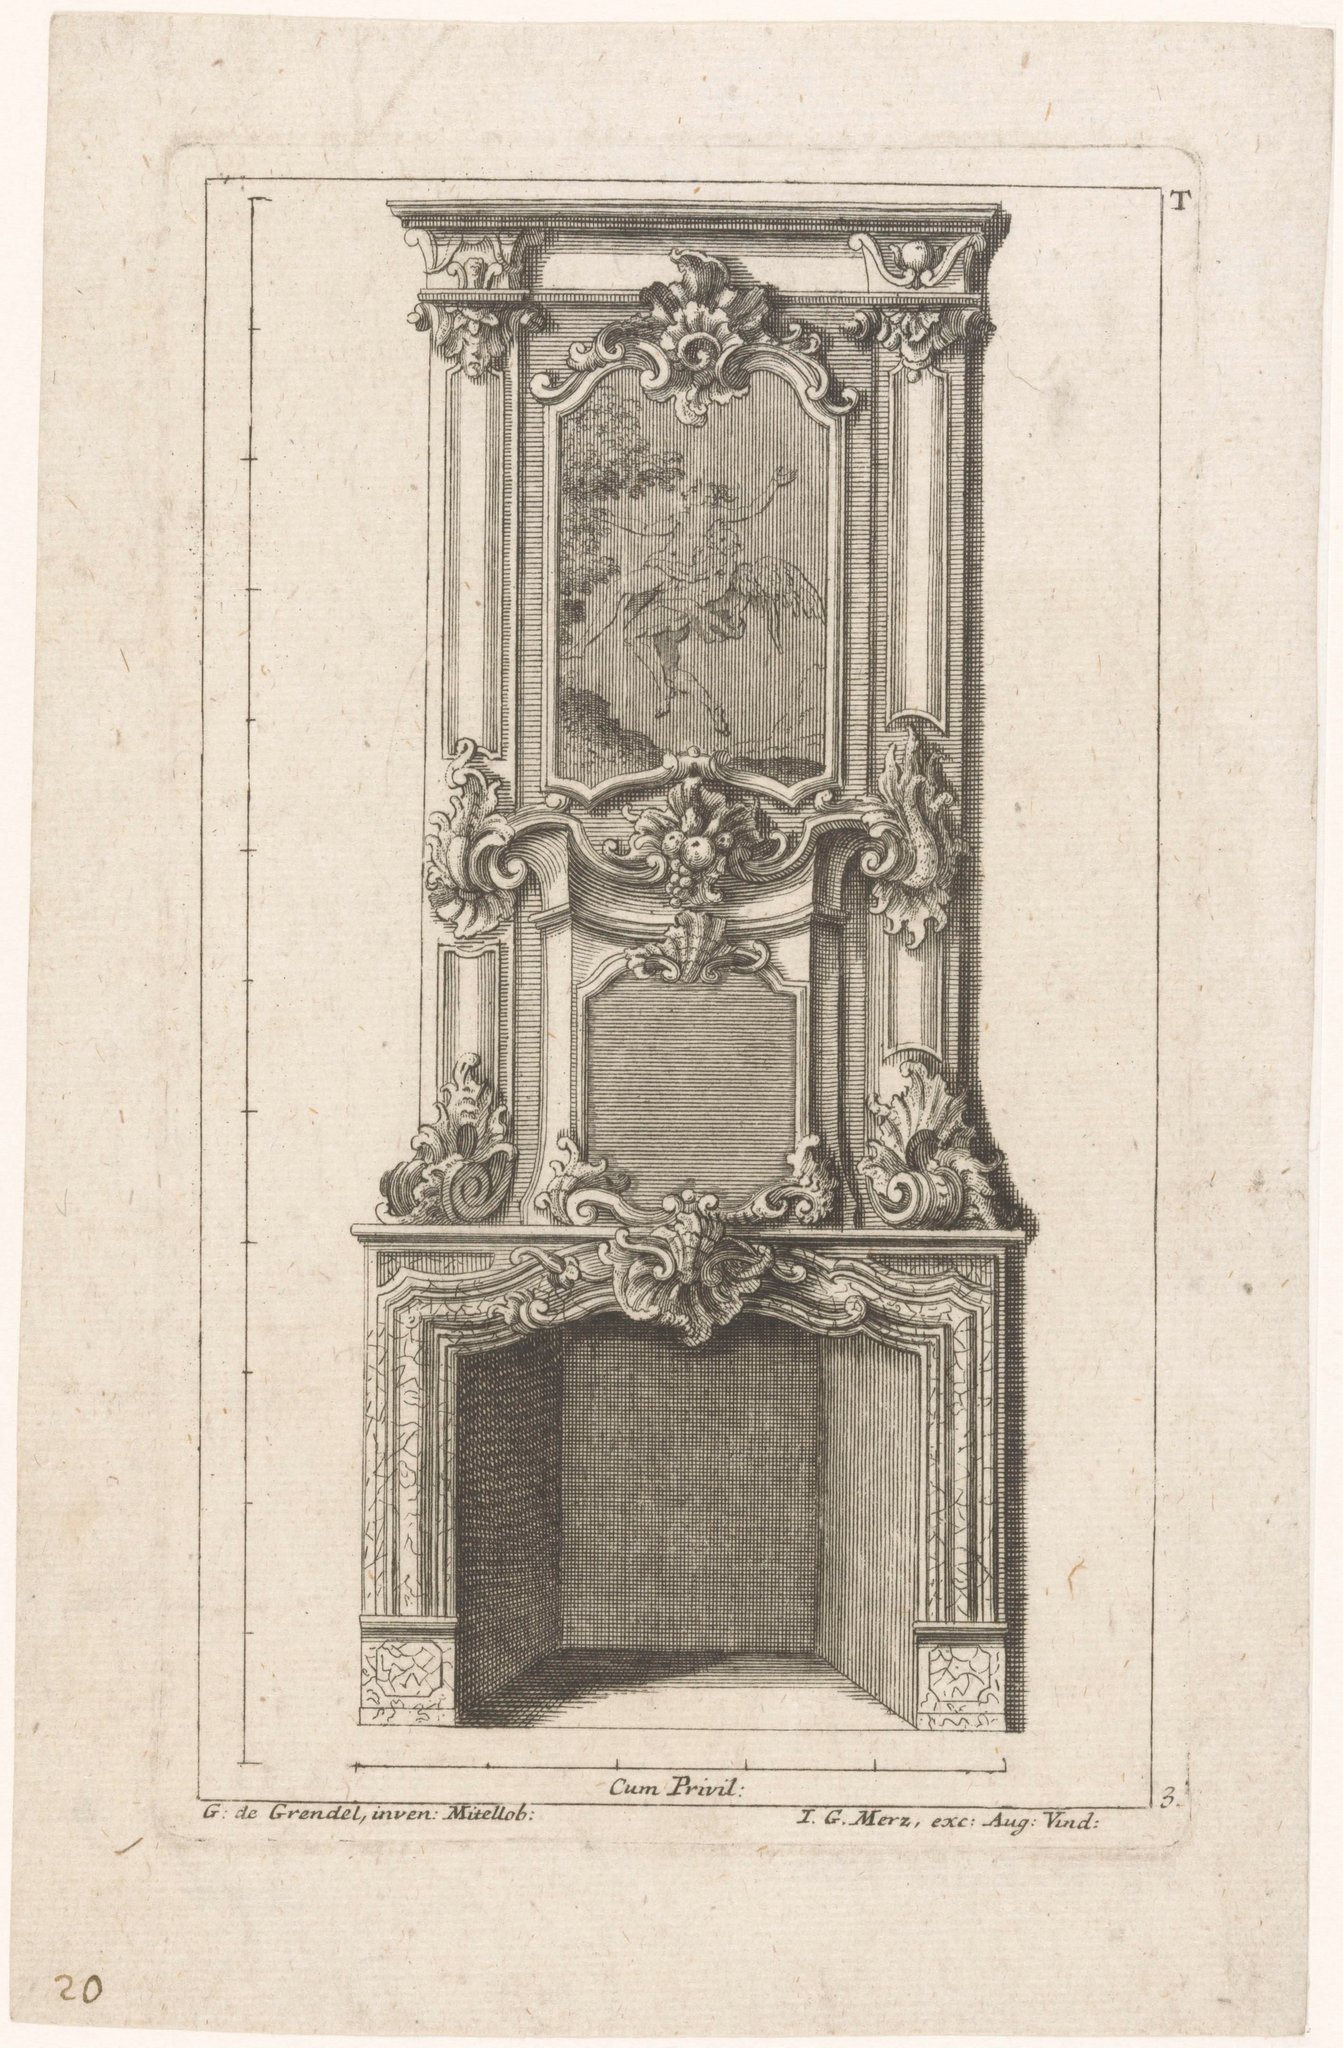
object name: ornament print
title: Neu inventirte Hollaendische Camine, Anderer Theil, serie T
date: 1704-1762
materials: paper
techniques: engraving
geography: augsburg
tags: chimney, boreas abducting orithyia, rocaille ornament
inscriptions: collector's mark: Lugt 2228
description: Ontwerp voor een schoorsteen met een voorstelling van Boreas die Oreithyia ontvoert. De schoorsteenmantel is versierd met rocailleornamenten, voluten en vruchten.